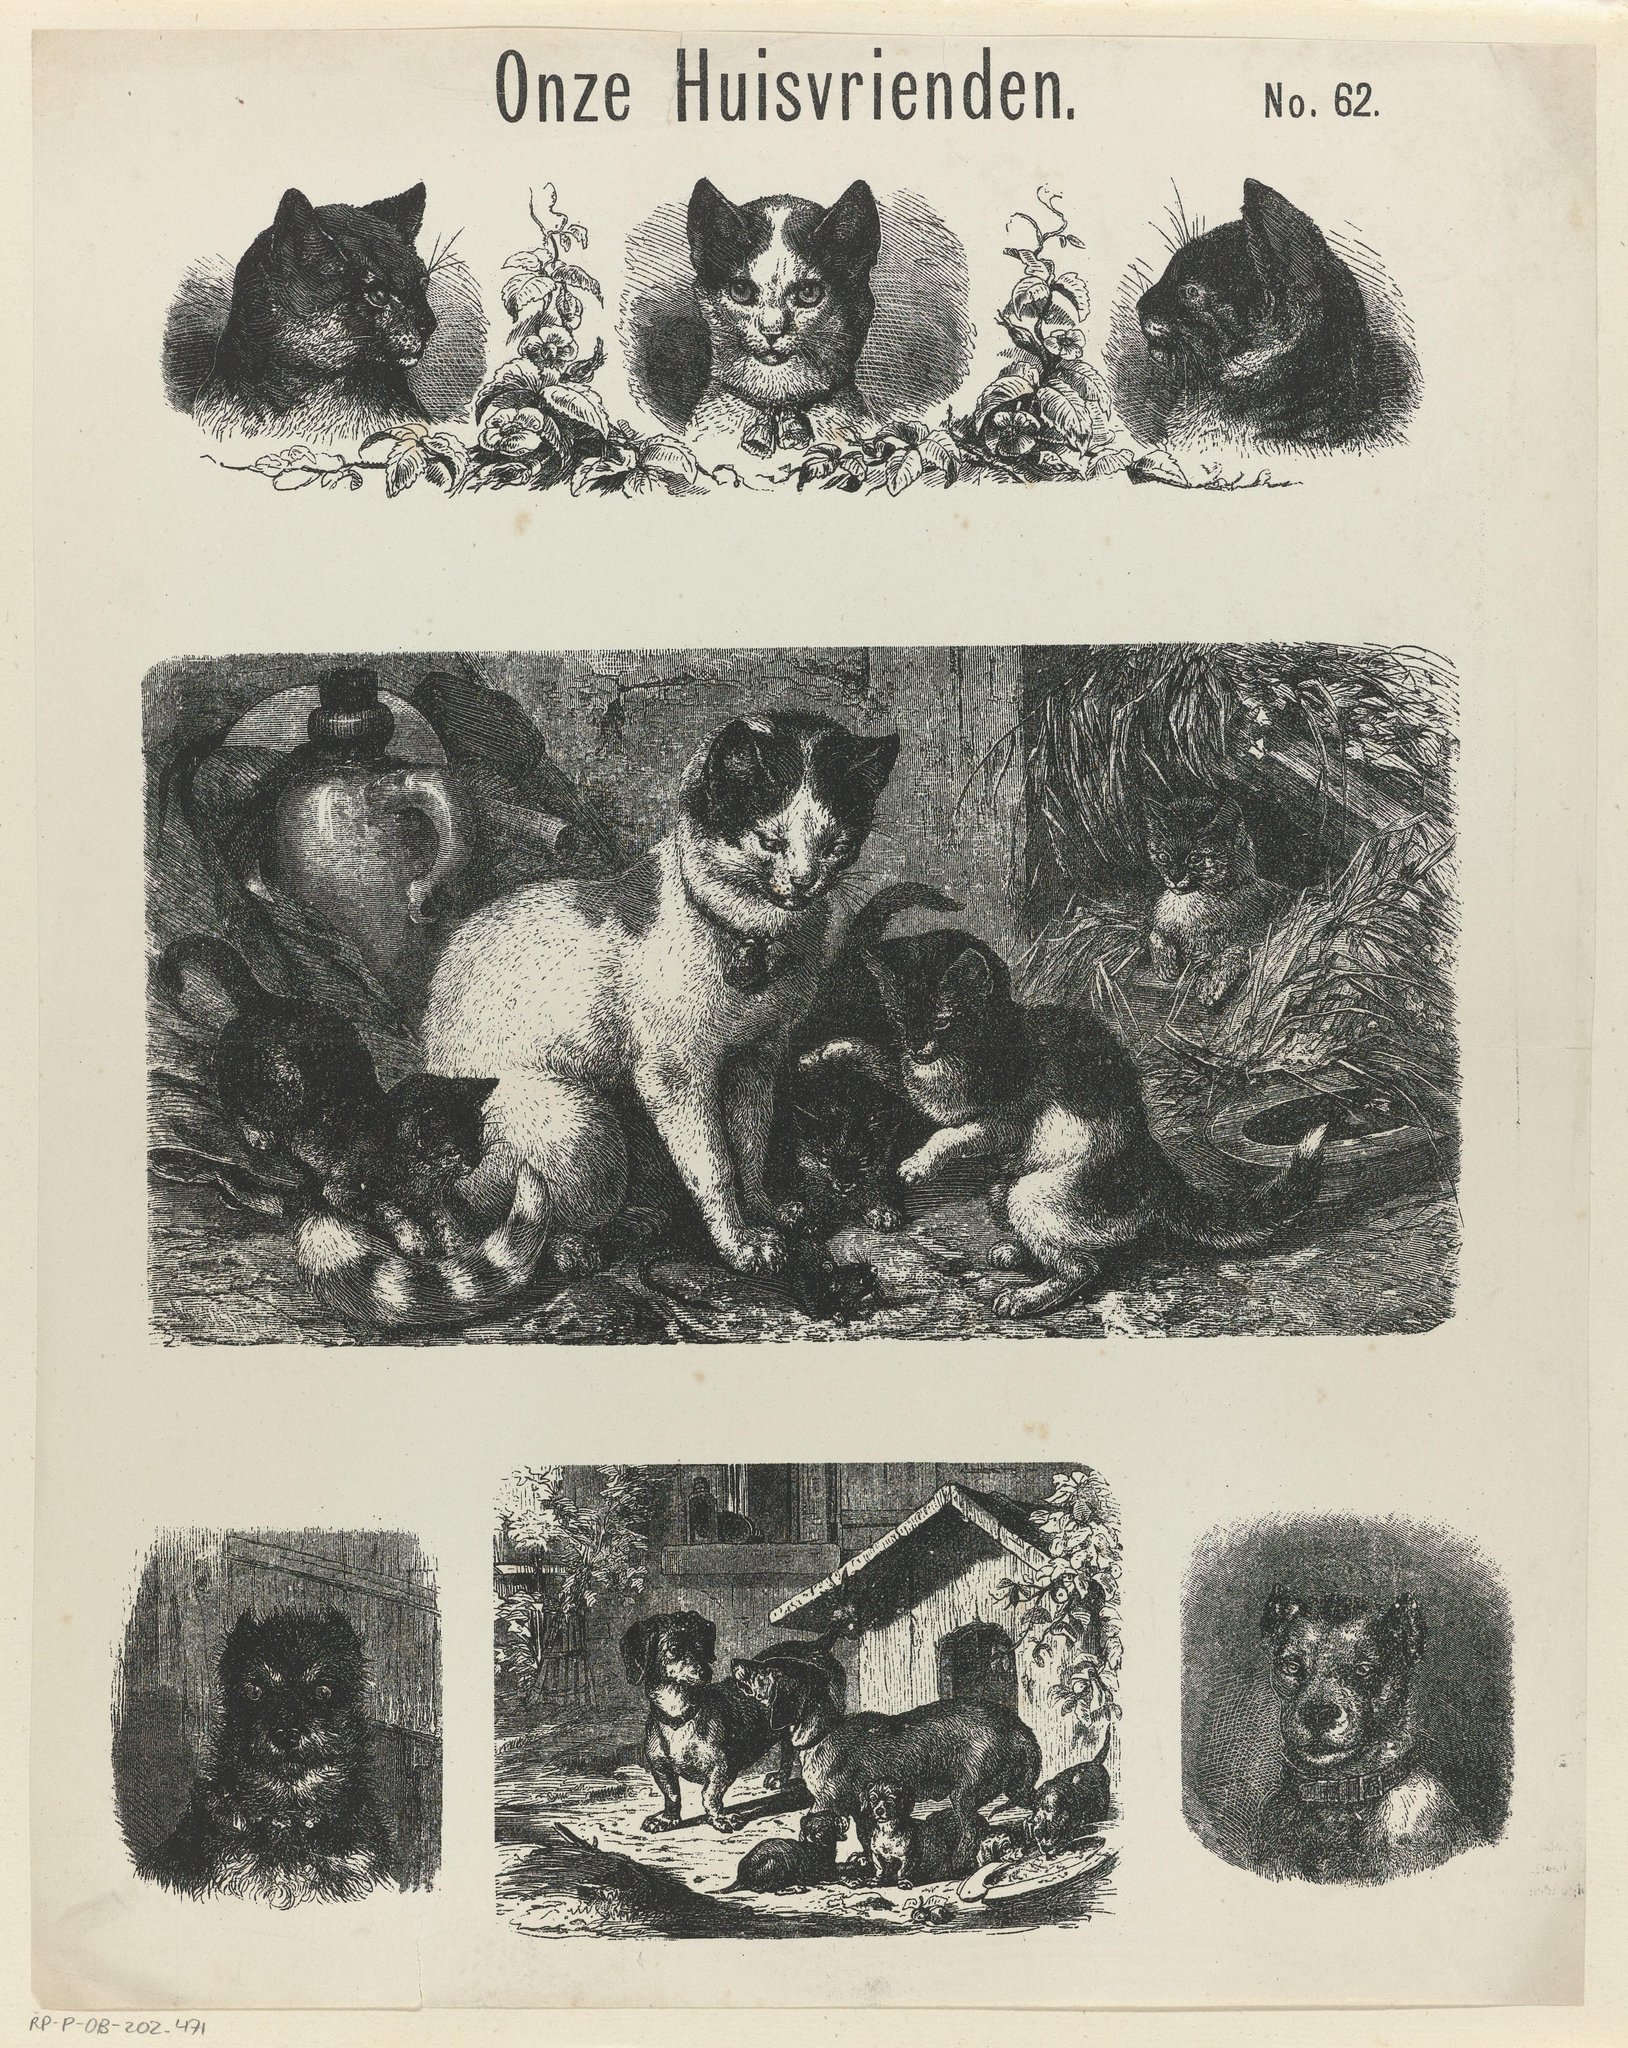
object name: popular print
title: Onze huisvrienden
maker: Anonymous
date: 1878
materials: paper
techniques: letterpress printing, lithograph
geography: amsterdam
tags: cat, dog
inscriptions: collector's mark: Lugt 2760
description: Blad met 7 voorstellingen van honden en katten. Genummerd rechtsboven: No. 62.